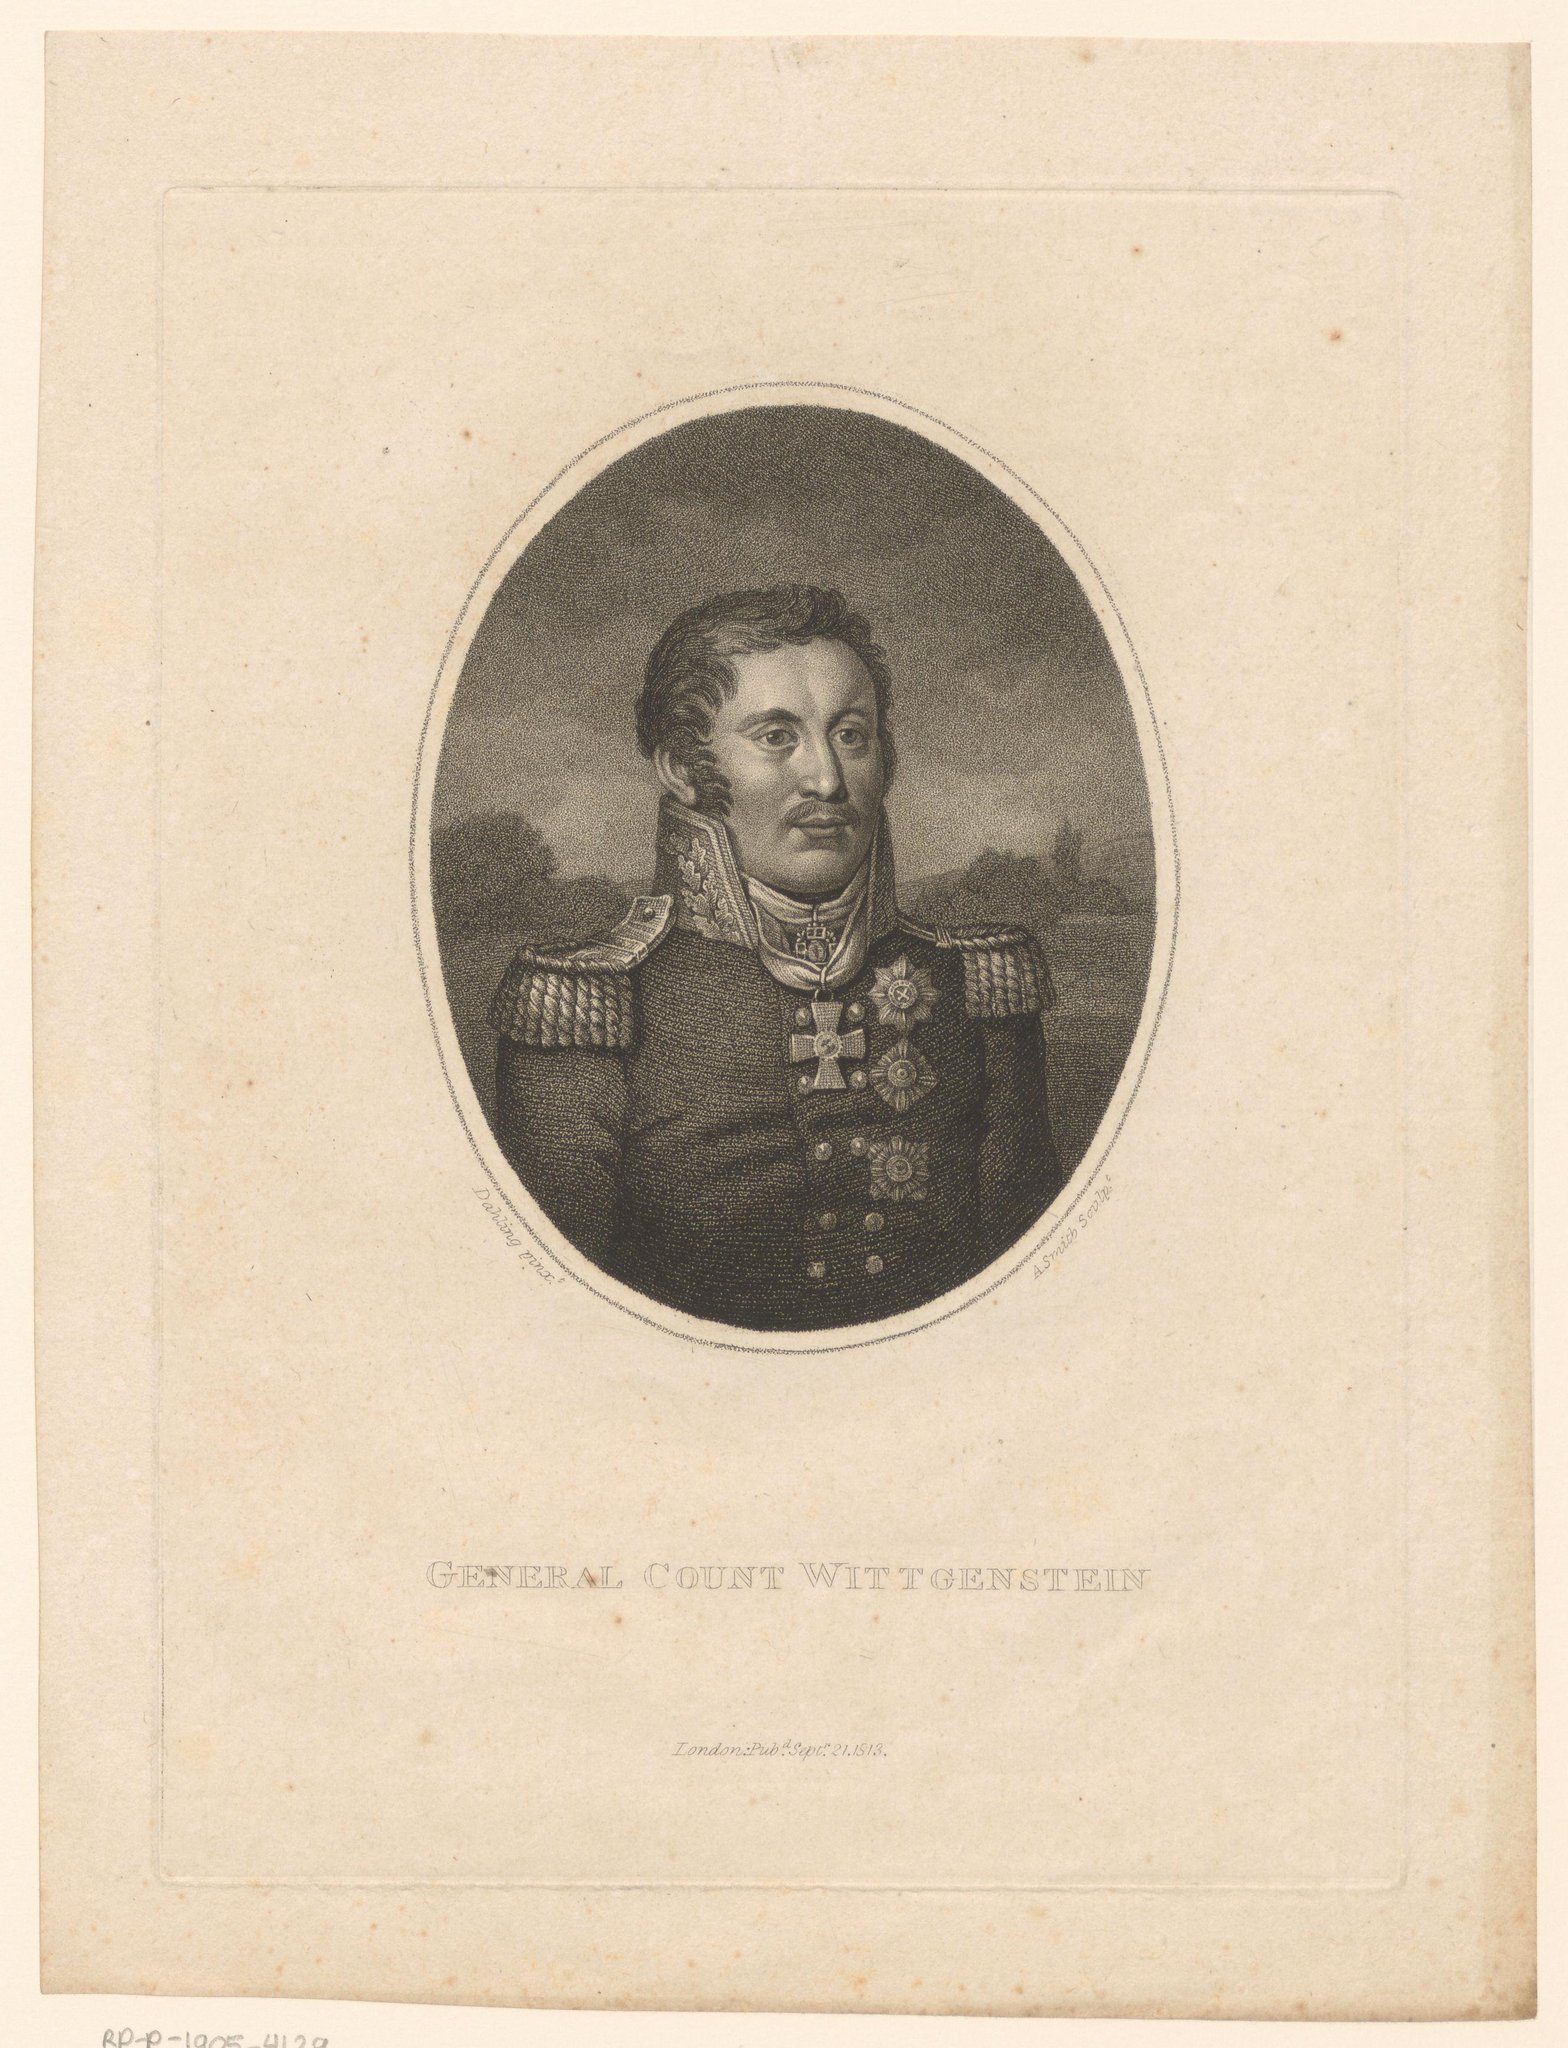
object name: print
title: General Count Wittgenstein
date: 1809-1813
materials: paper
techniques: engraving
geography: great britain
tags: commander-in-chief, general, marshal, historical persons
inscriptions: collector's mark: Lugt 2228